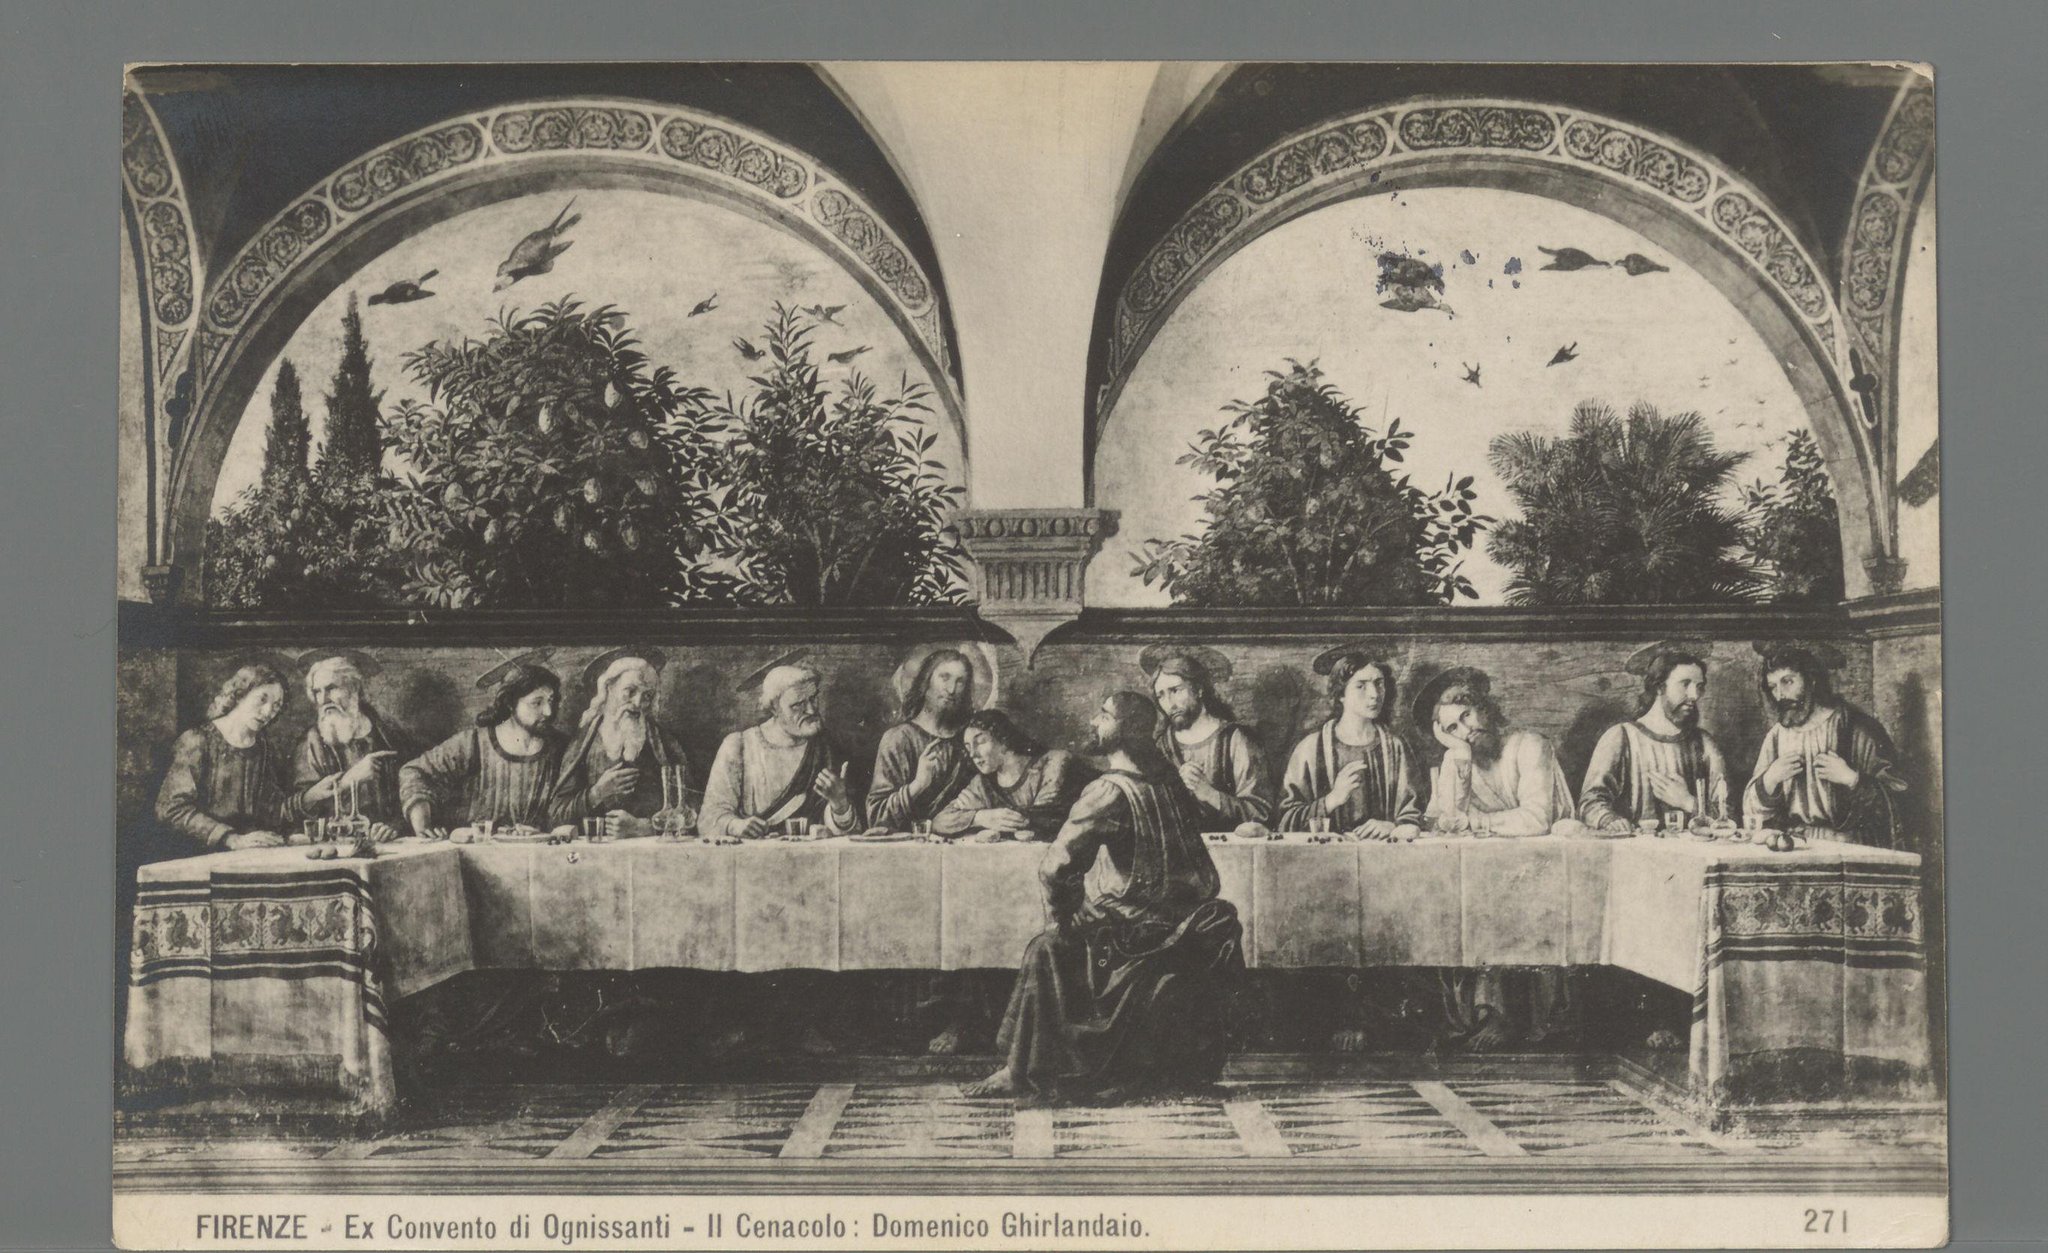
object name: photograph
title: Firenze - Ex Convento di Ognissanti - Il Cenacolo: Domenico Ghirlandaio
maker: Anonymous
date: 1906-1930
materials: paper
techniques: gelatin silver print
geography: florence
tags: abbey, monastery, convent ~ roman catholic church, picture, painting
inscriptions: collector's mark: ‘AFE v S’